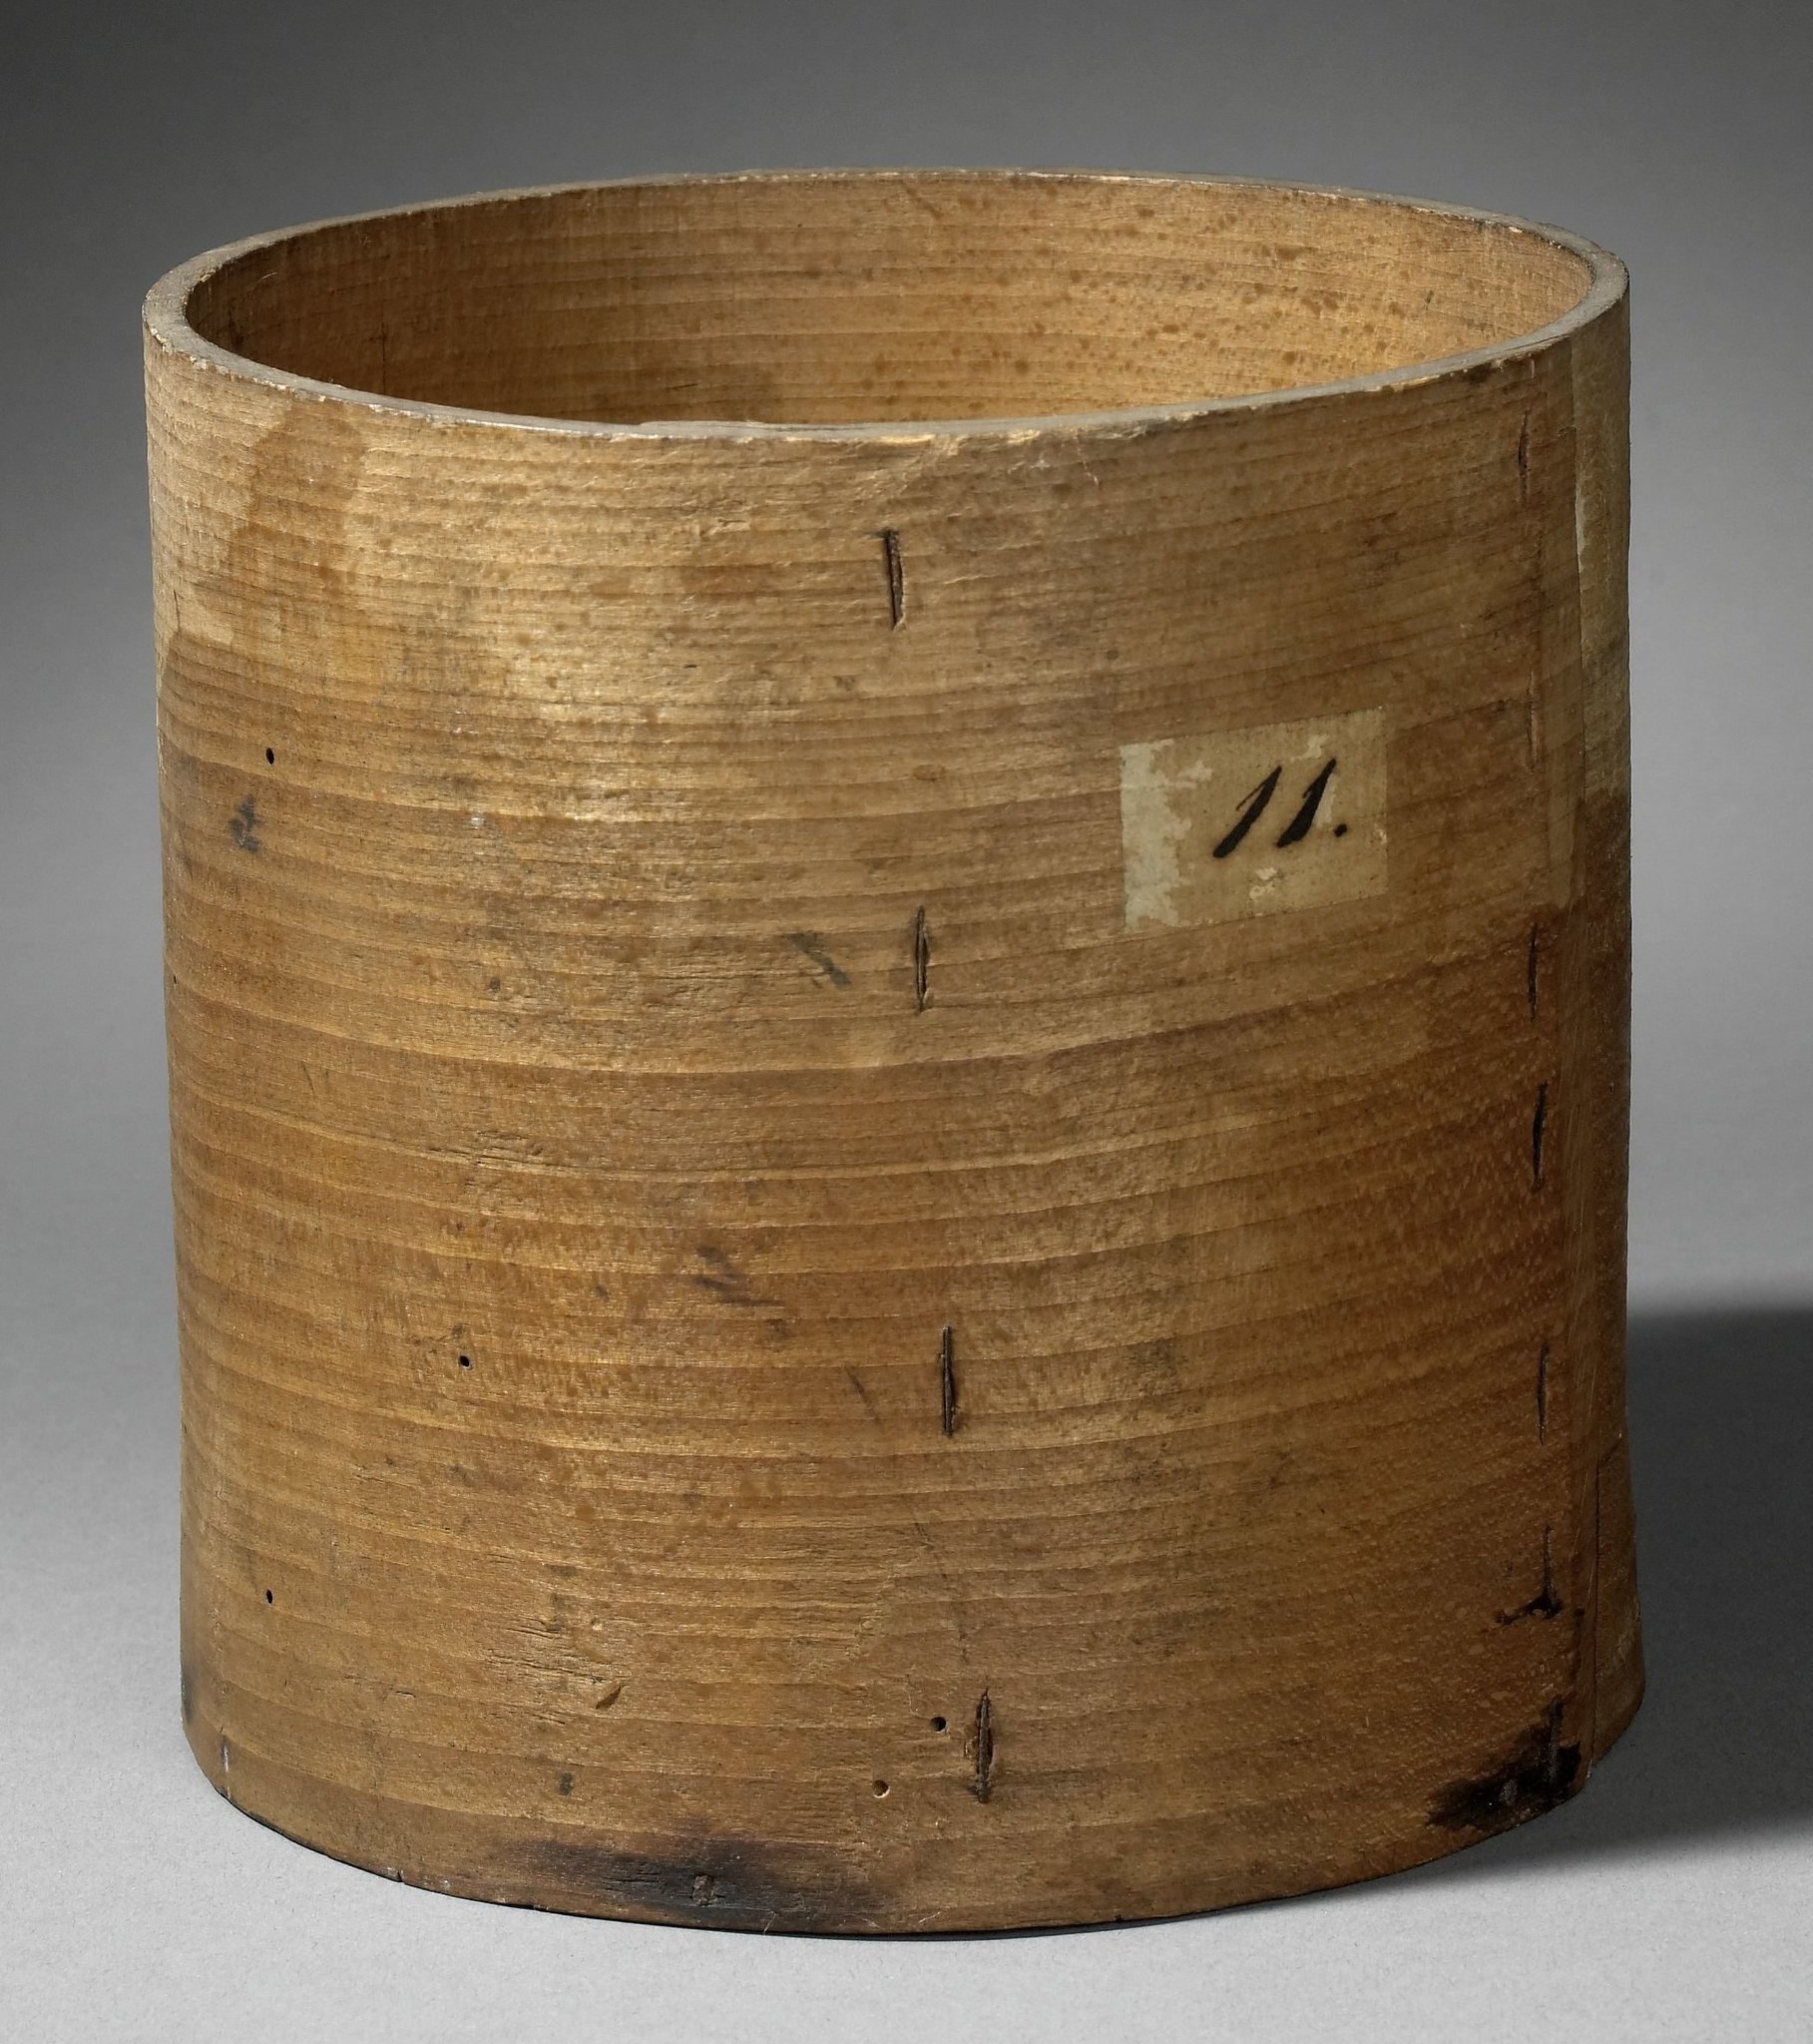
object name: inhoudsmaat droge waren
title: Inhoudsmaat van 2 l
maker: Anonymous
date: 1820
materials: wood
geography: netherlands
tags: netherlands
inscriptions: number: ‘11’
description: Spanen inhoudsmaat van 2 l. Geen opschriften of merken, wel etiketten